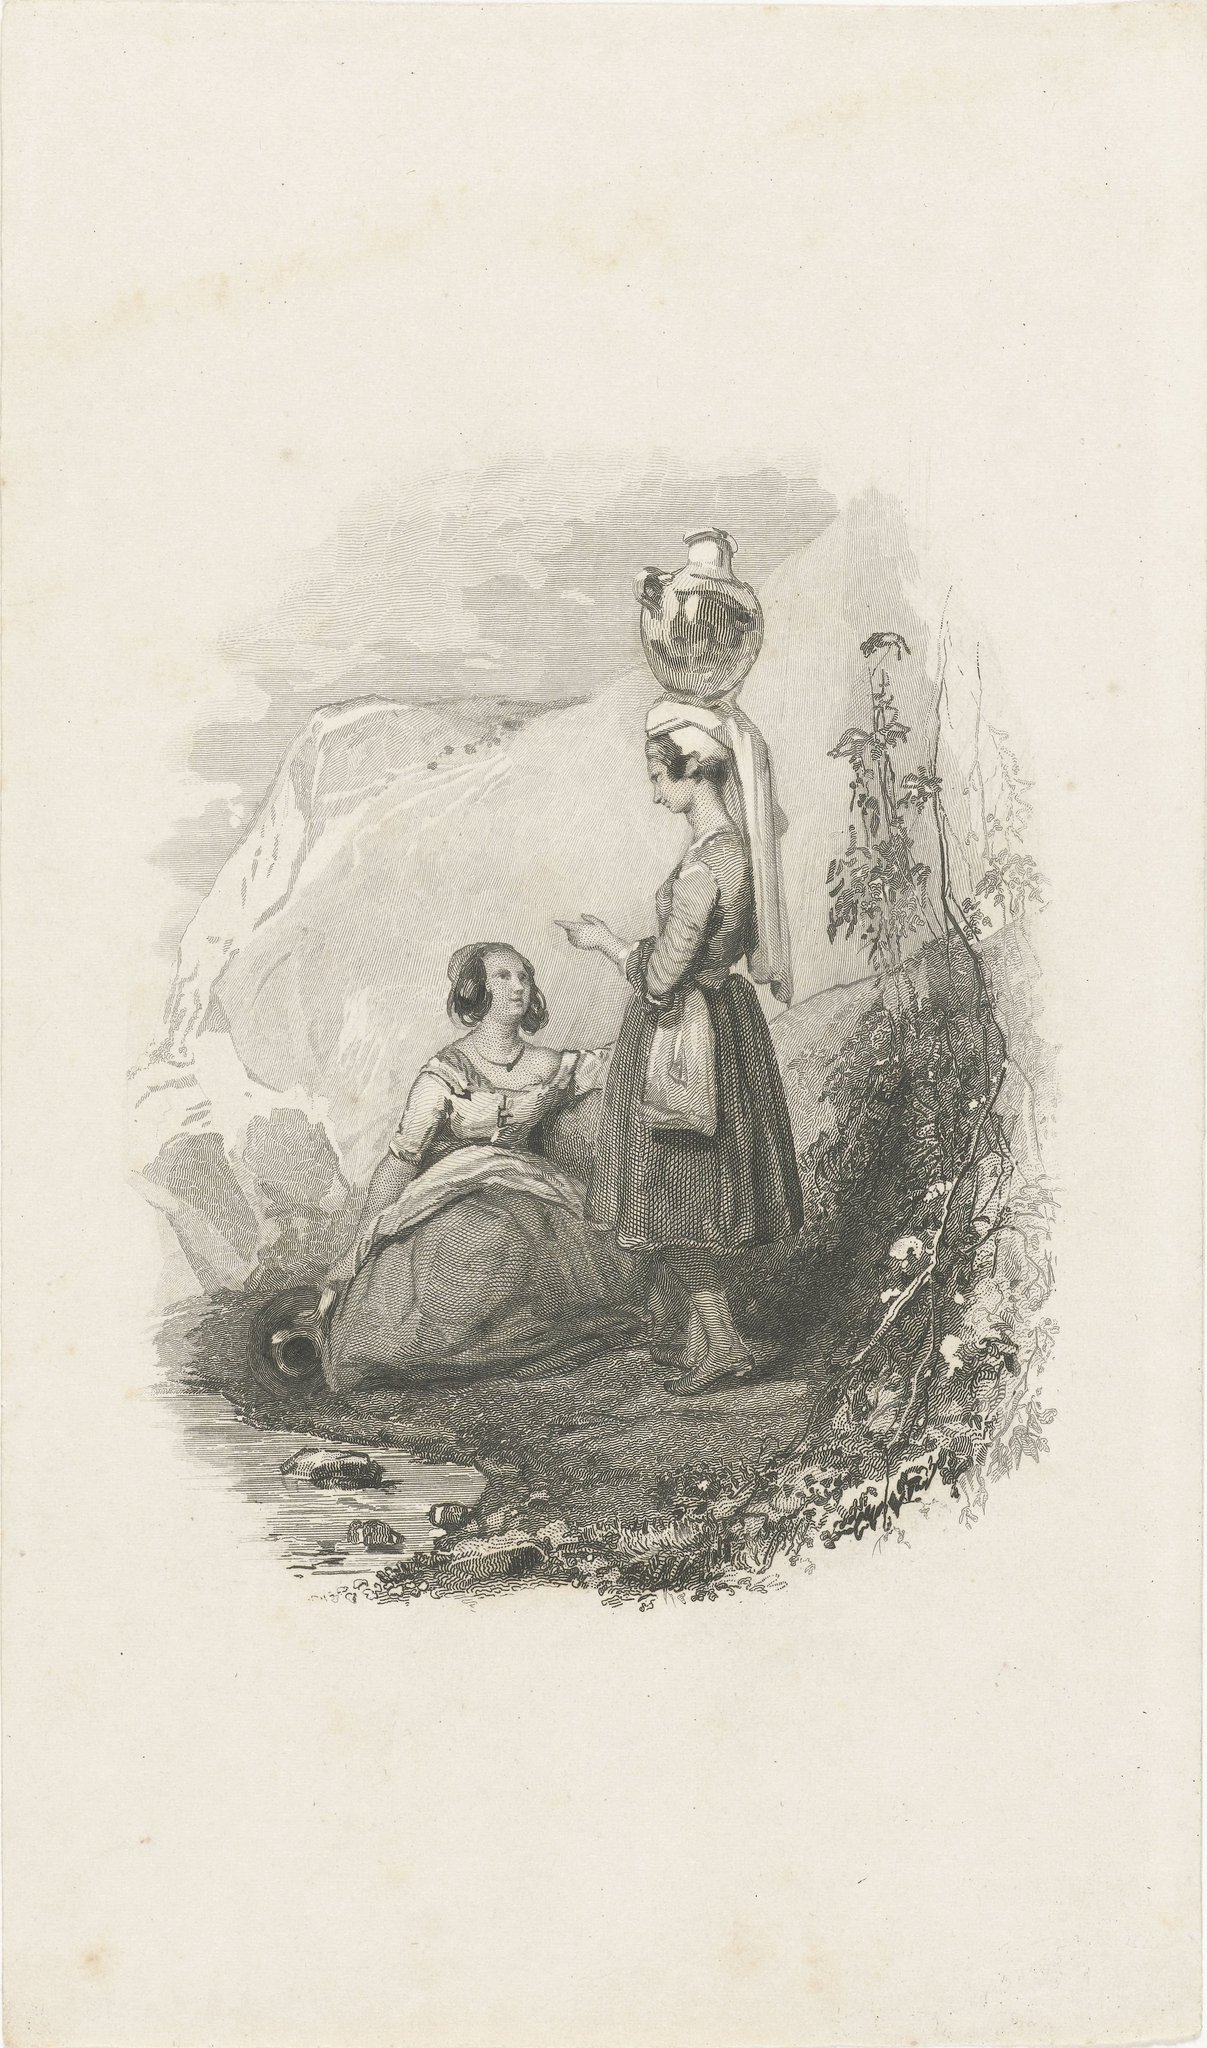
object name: book illustration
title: Twee waterdraagsters rusten uit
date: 1830-1845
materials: paper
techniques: engraving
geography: amsterdam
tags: resting - bb - out of doors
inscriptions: collector's mark: Lugt 2228